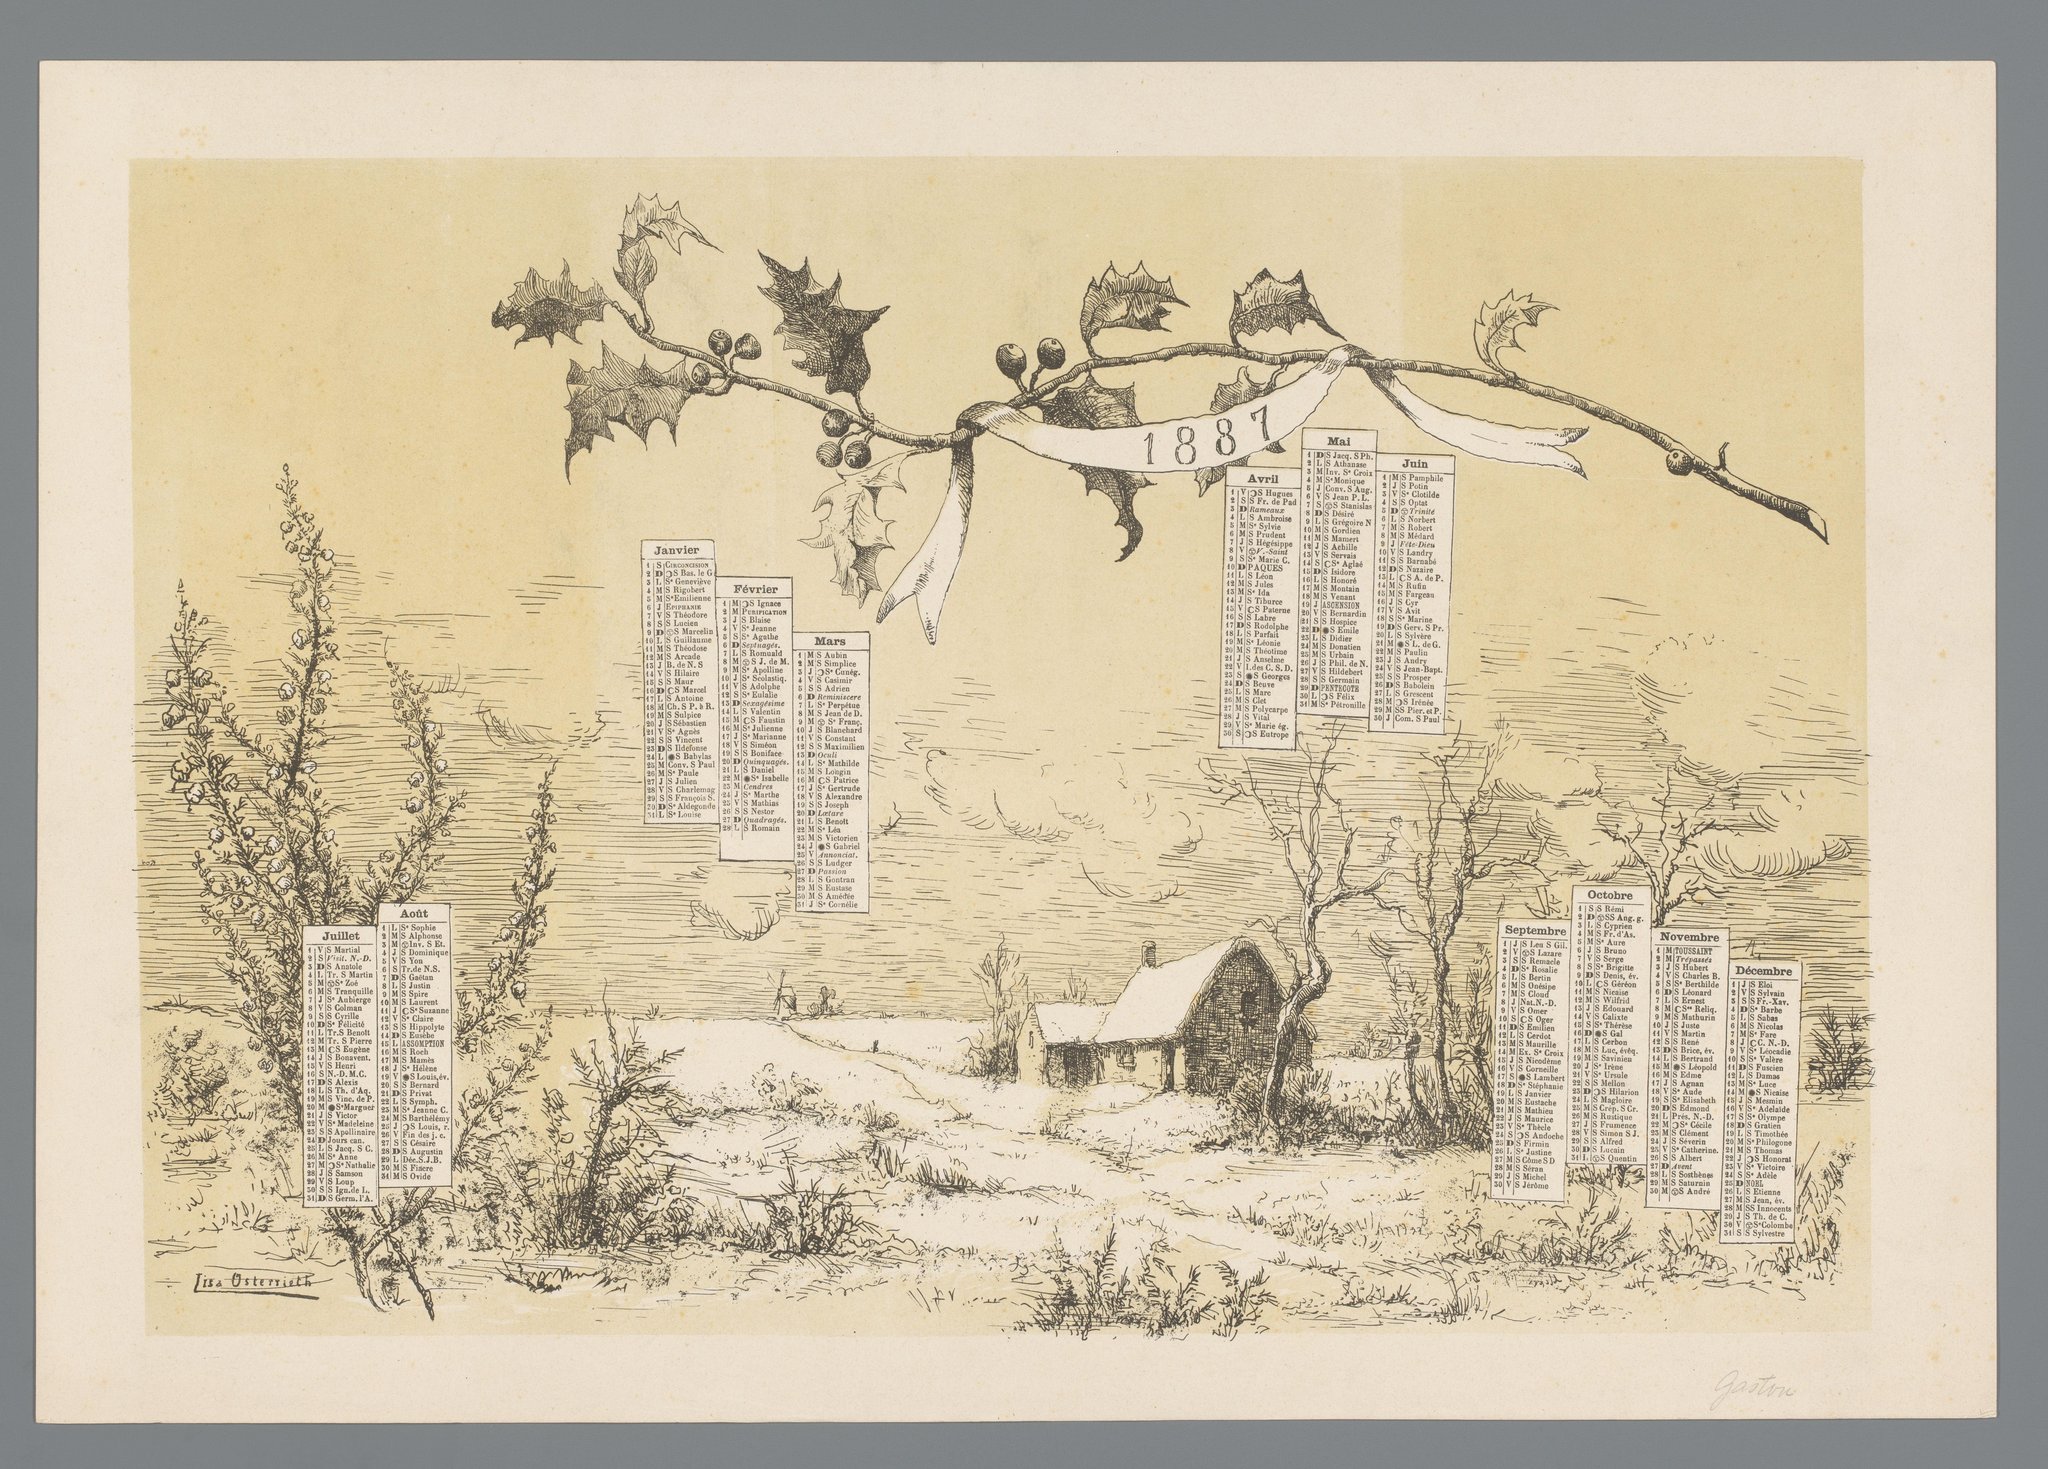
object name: calendar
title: Kalender van 1887 met winterlandschap en hulsttak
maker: elisa osterrieth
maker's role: print maker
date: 1887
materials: paper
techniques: tone lithography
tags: plants and herbs: holly, winter landscape; landscape symbolizing winter (the four seasons of the year), farm or solitary house in landscape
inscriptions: collector's mark: Lugt 2228